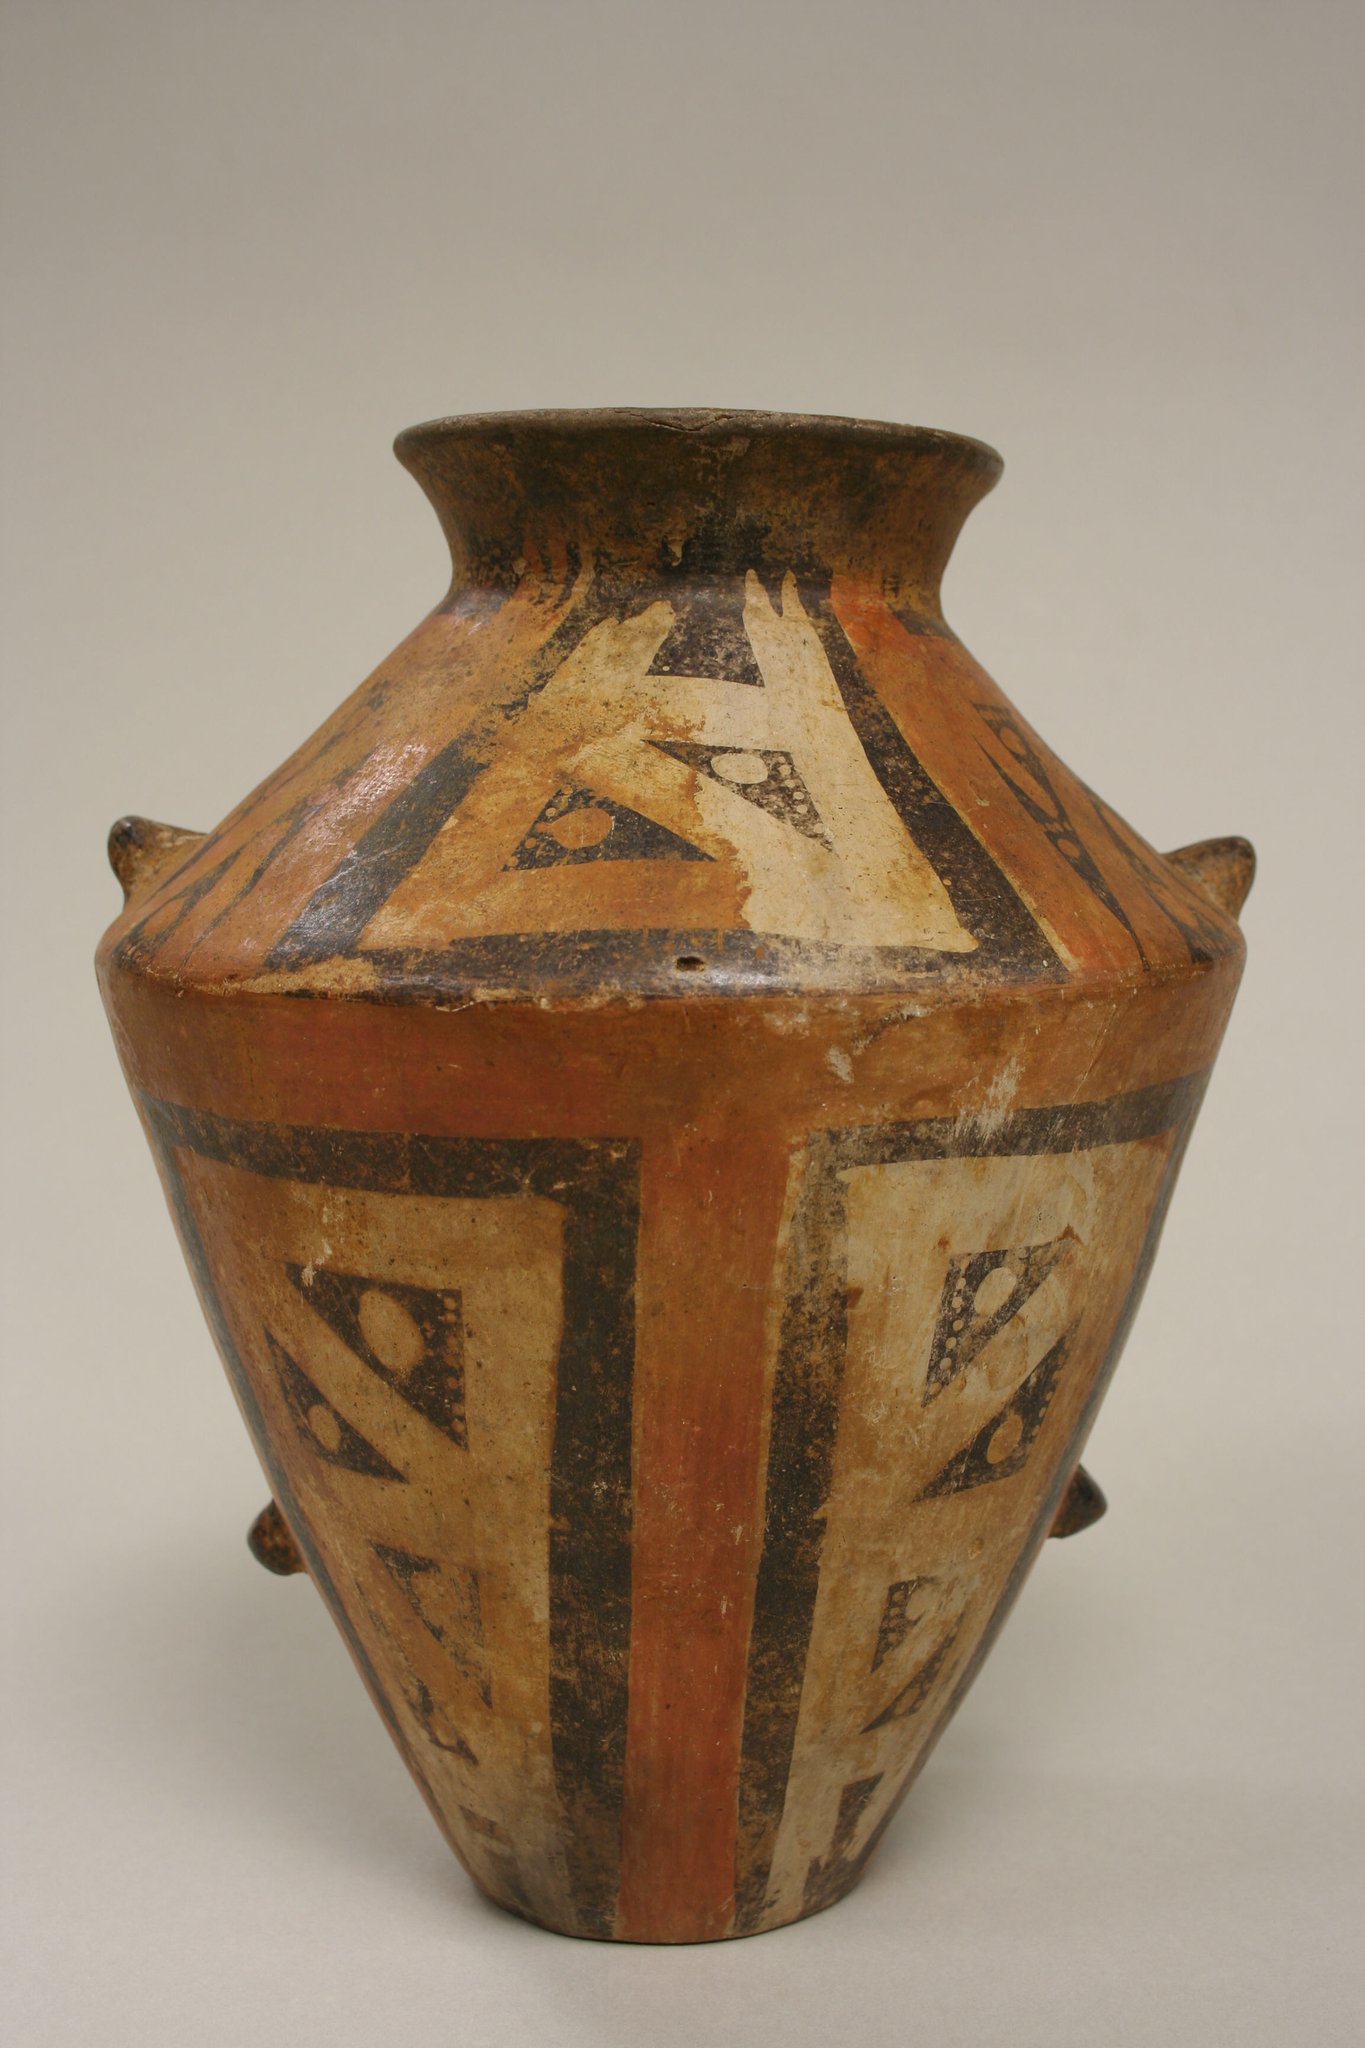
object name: jar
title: Jar, Geometric Pattern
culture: quimbaya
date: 801-1400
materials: ceramic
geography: colombia